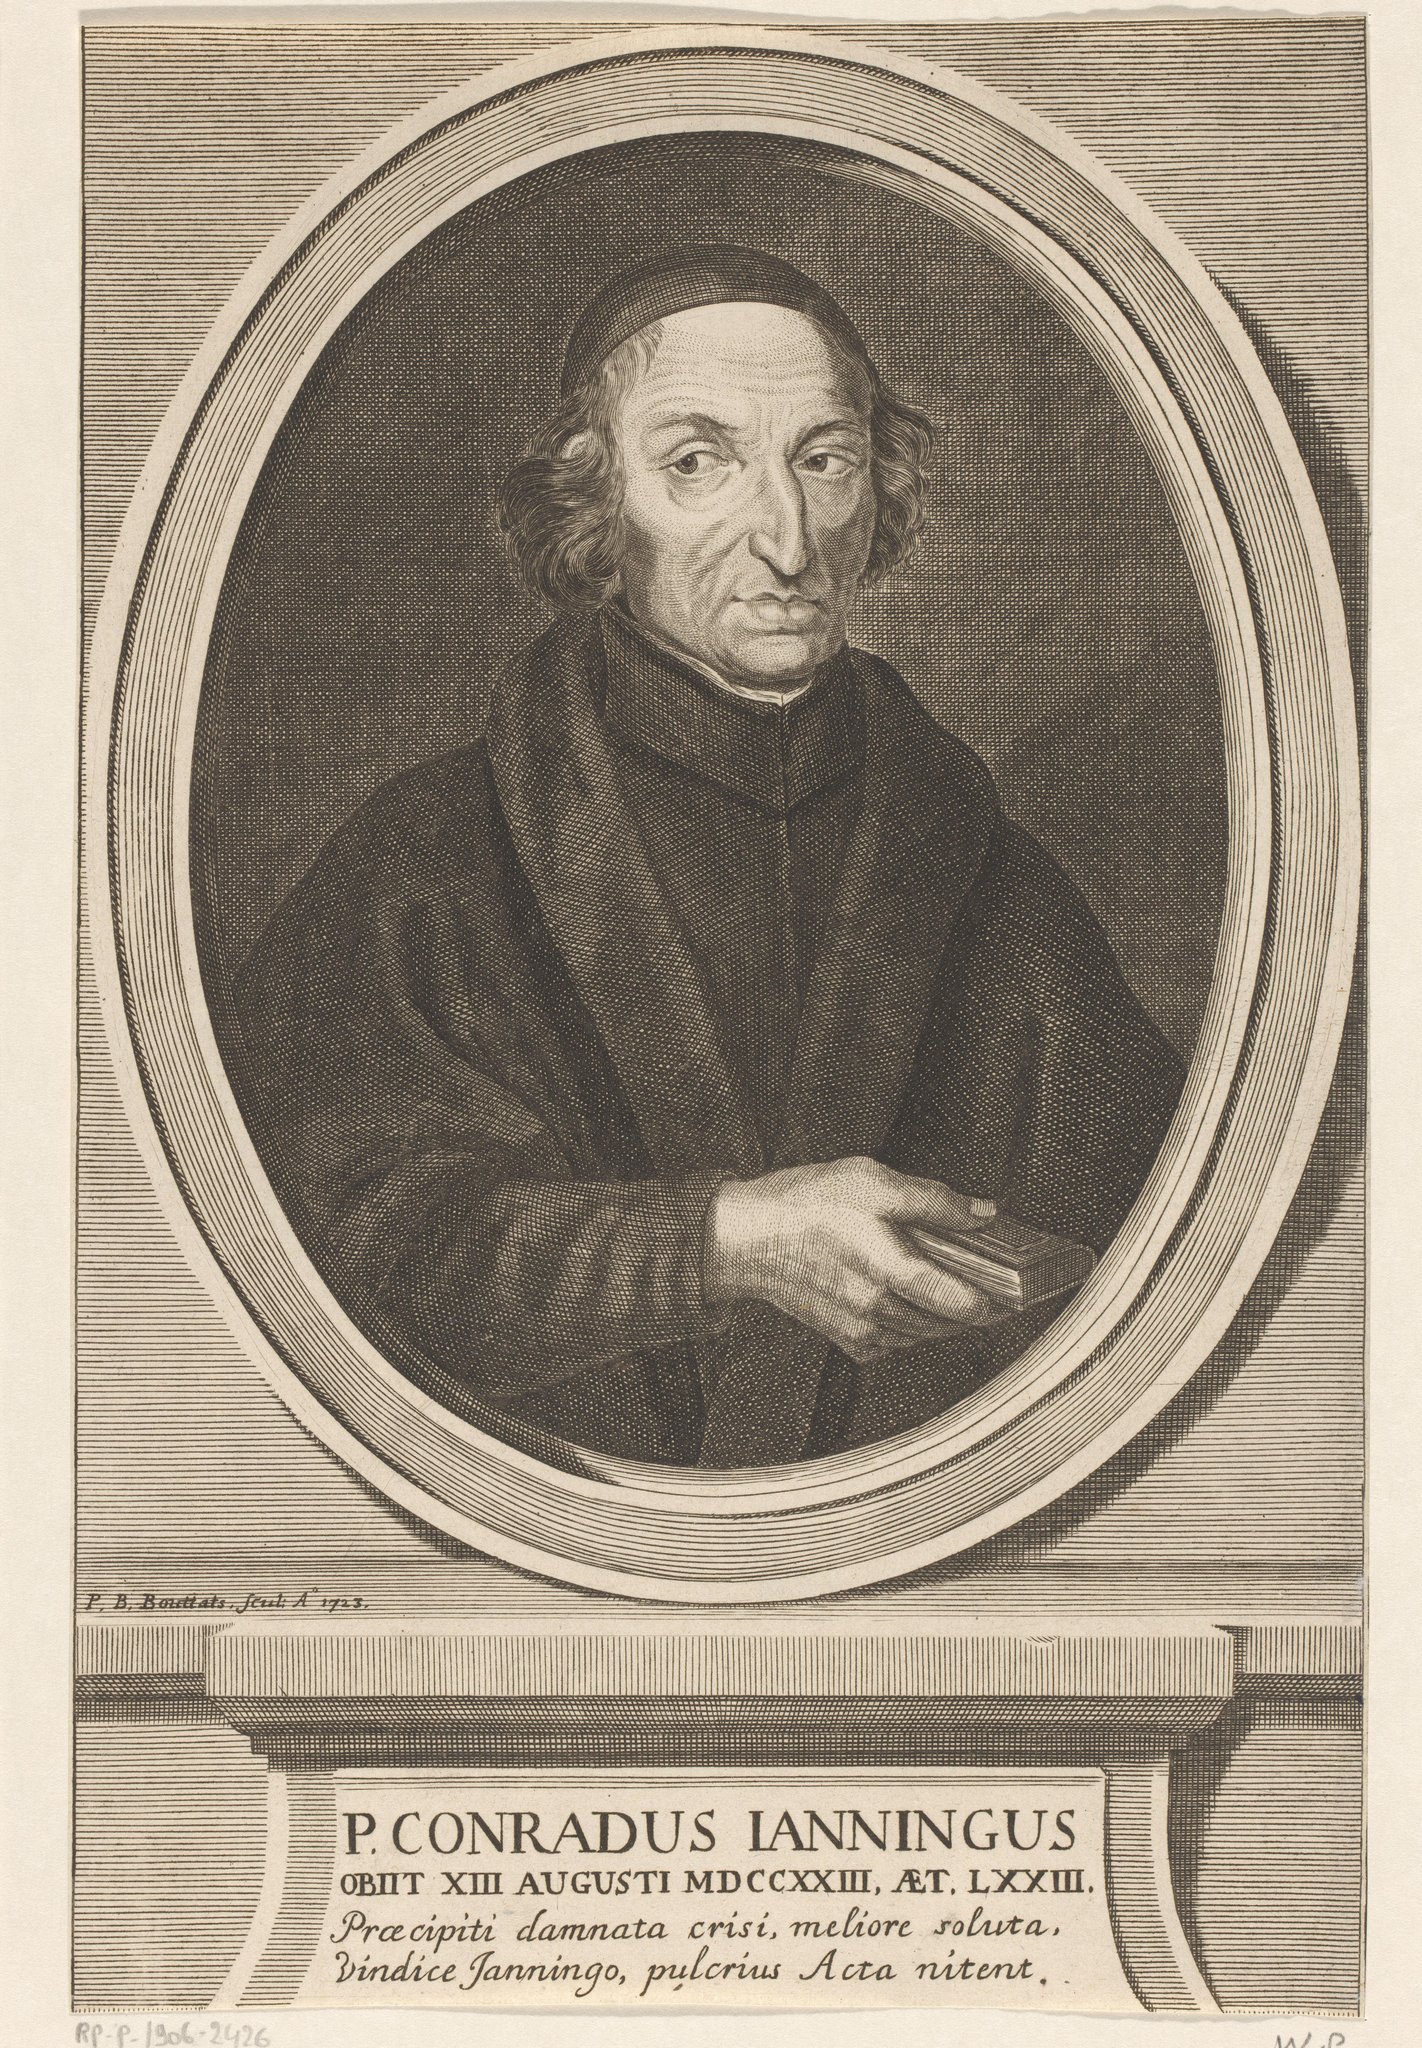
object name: print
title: Portret van Conrad Janninck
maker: pieter balthasar bouttats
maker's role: print maker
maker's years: 1666-1755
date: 1723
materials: paper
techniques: engraving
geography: antwerp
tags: jezuïet, conrad janninck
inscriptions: collector's mark: Lugt 2228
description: Portret in ovale lijst van Conrad Janninck, Jezuïet en Bollandist. Buste naar rechts. Hij draagt een zwarte soutane. Middenonder naam van geportetteerde en Latijns onderschrift in cartouche.